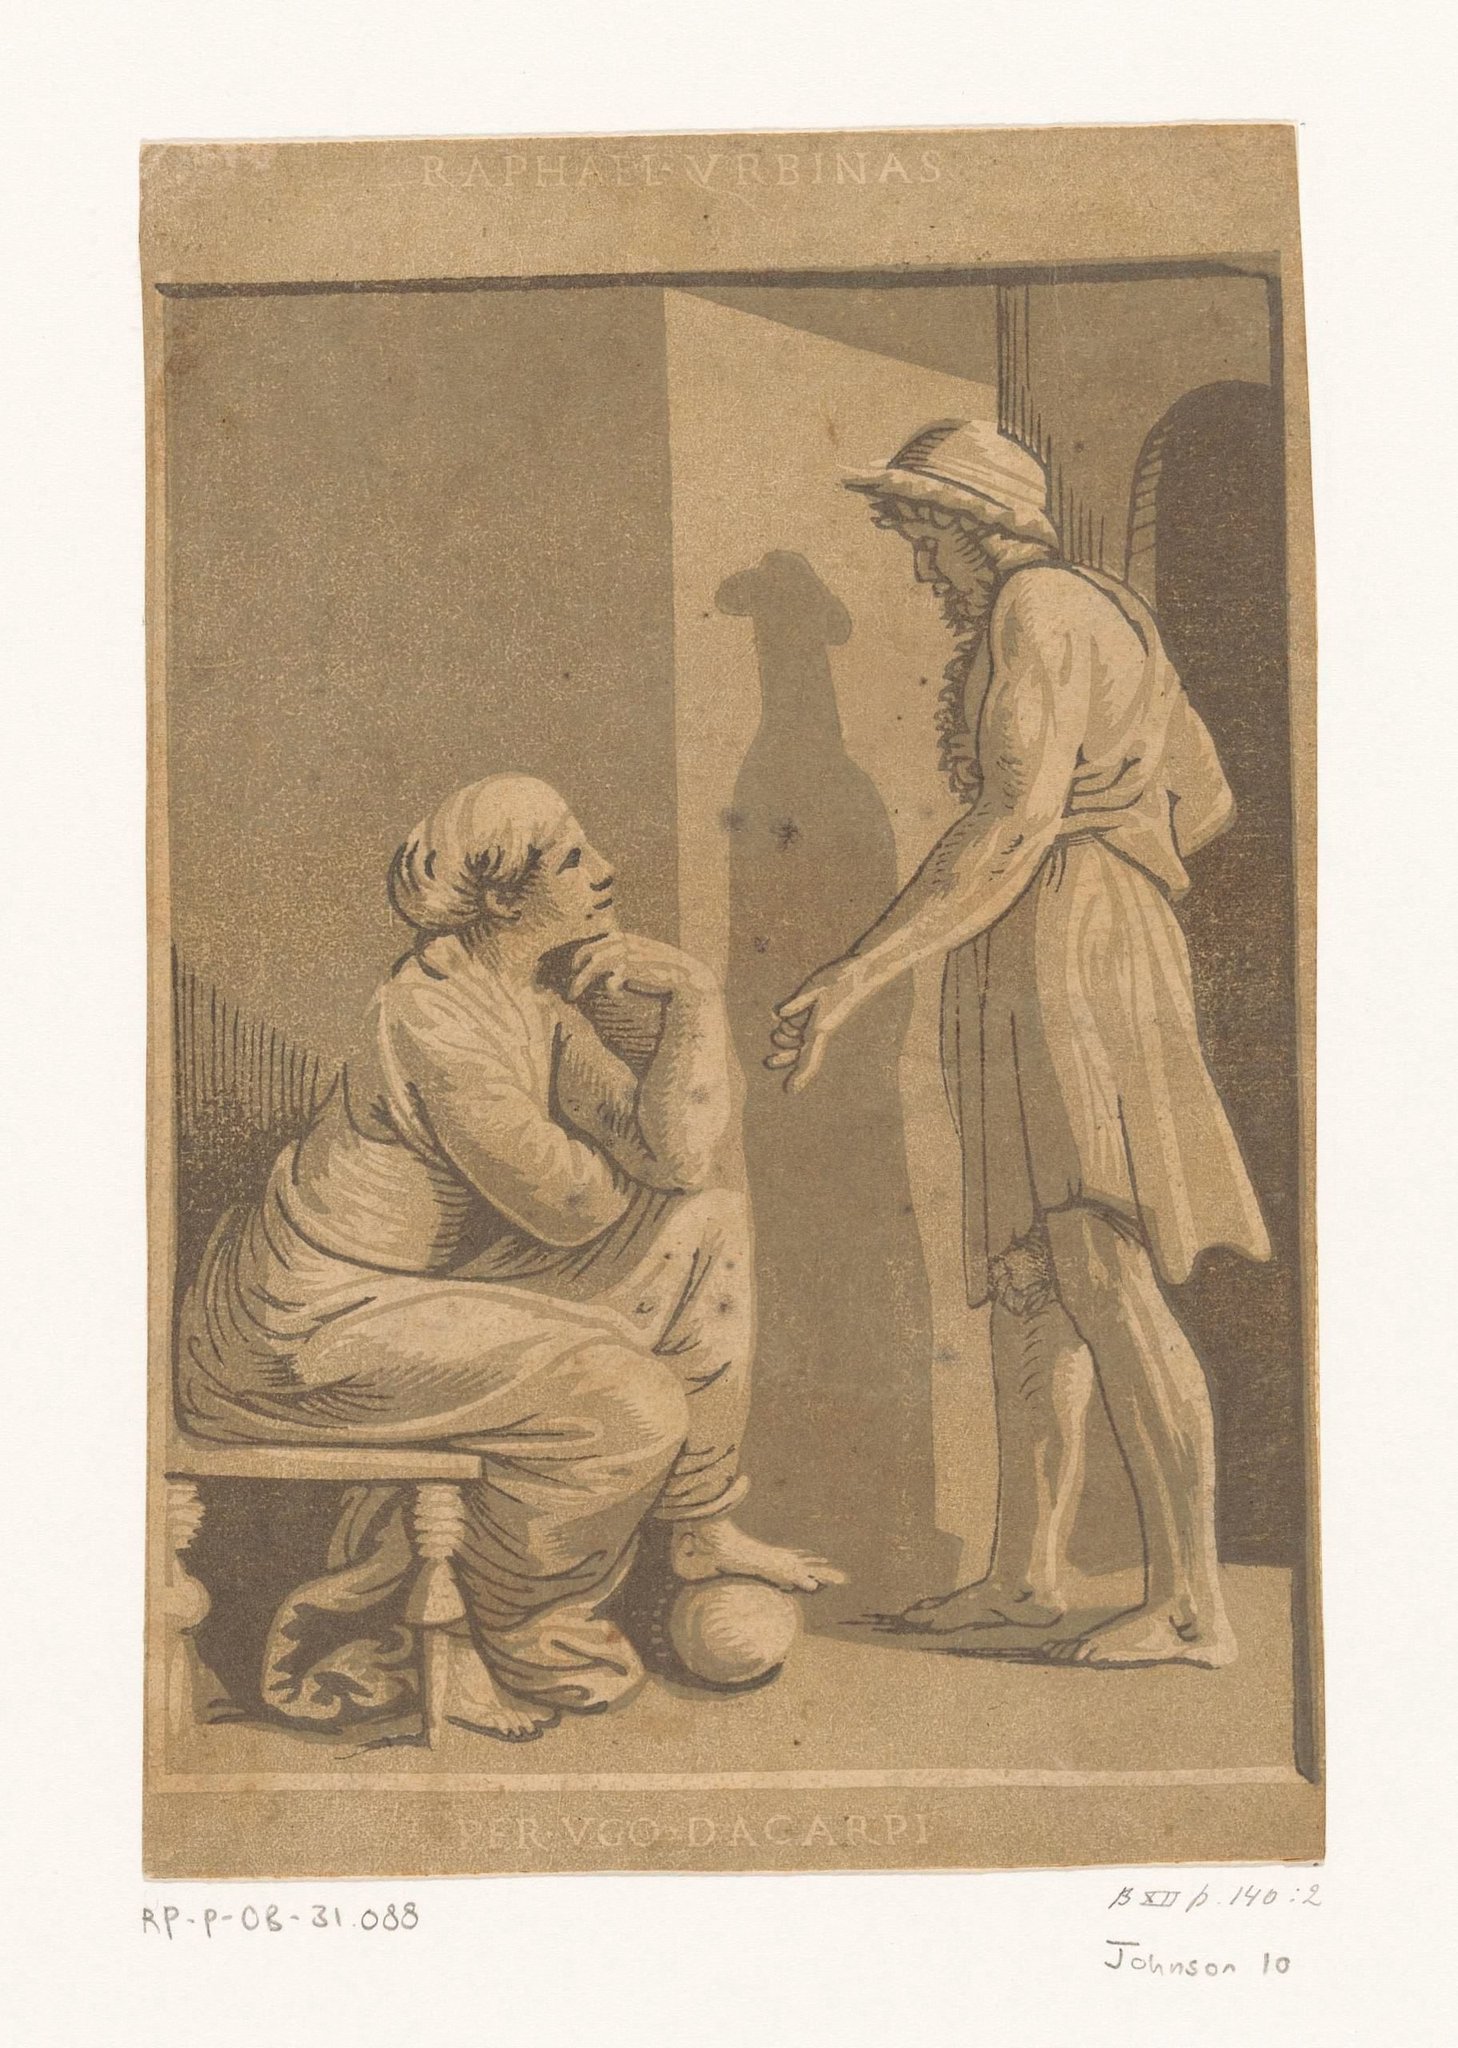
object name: print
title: Staande man en zittende vrouw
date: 1502-1532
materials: paper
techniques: woodcut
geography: italy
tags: rome, painter, rafaël, historical persons, mistress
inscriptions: collector's mark: Lugt 240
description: Rechts staat een man met een hoed. Links zit een vrouw met haar voet op een bol. Mogelijk de kunstenaar Rafaël en zijn maîtresse.